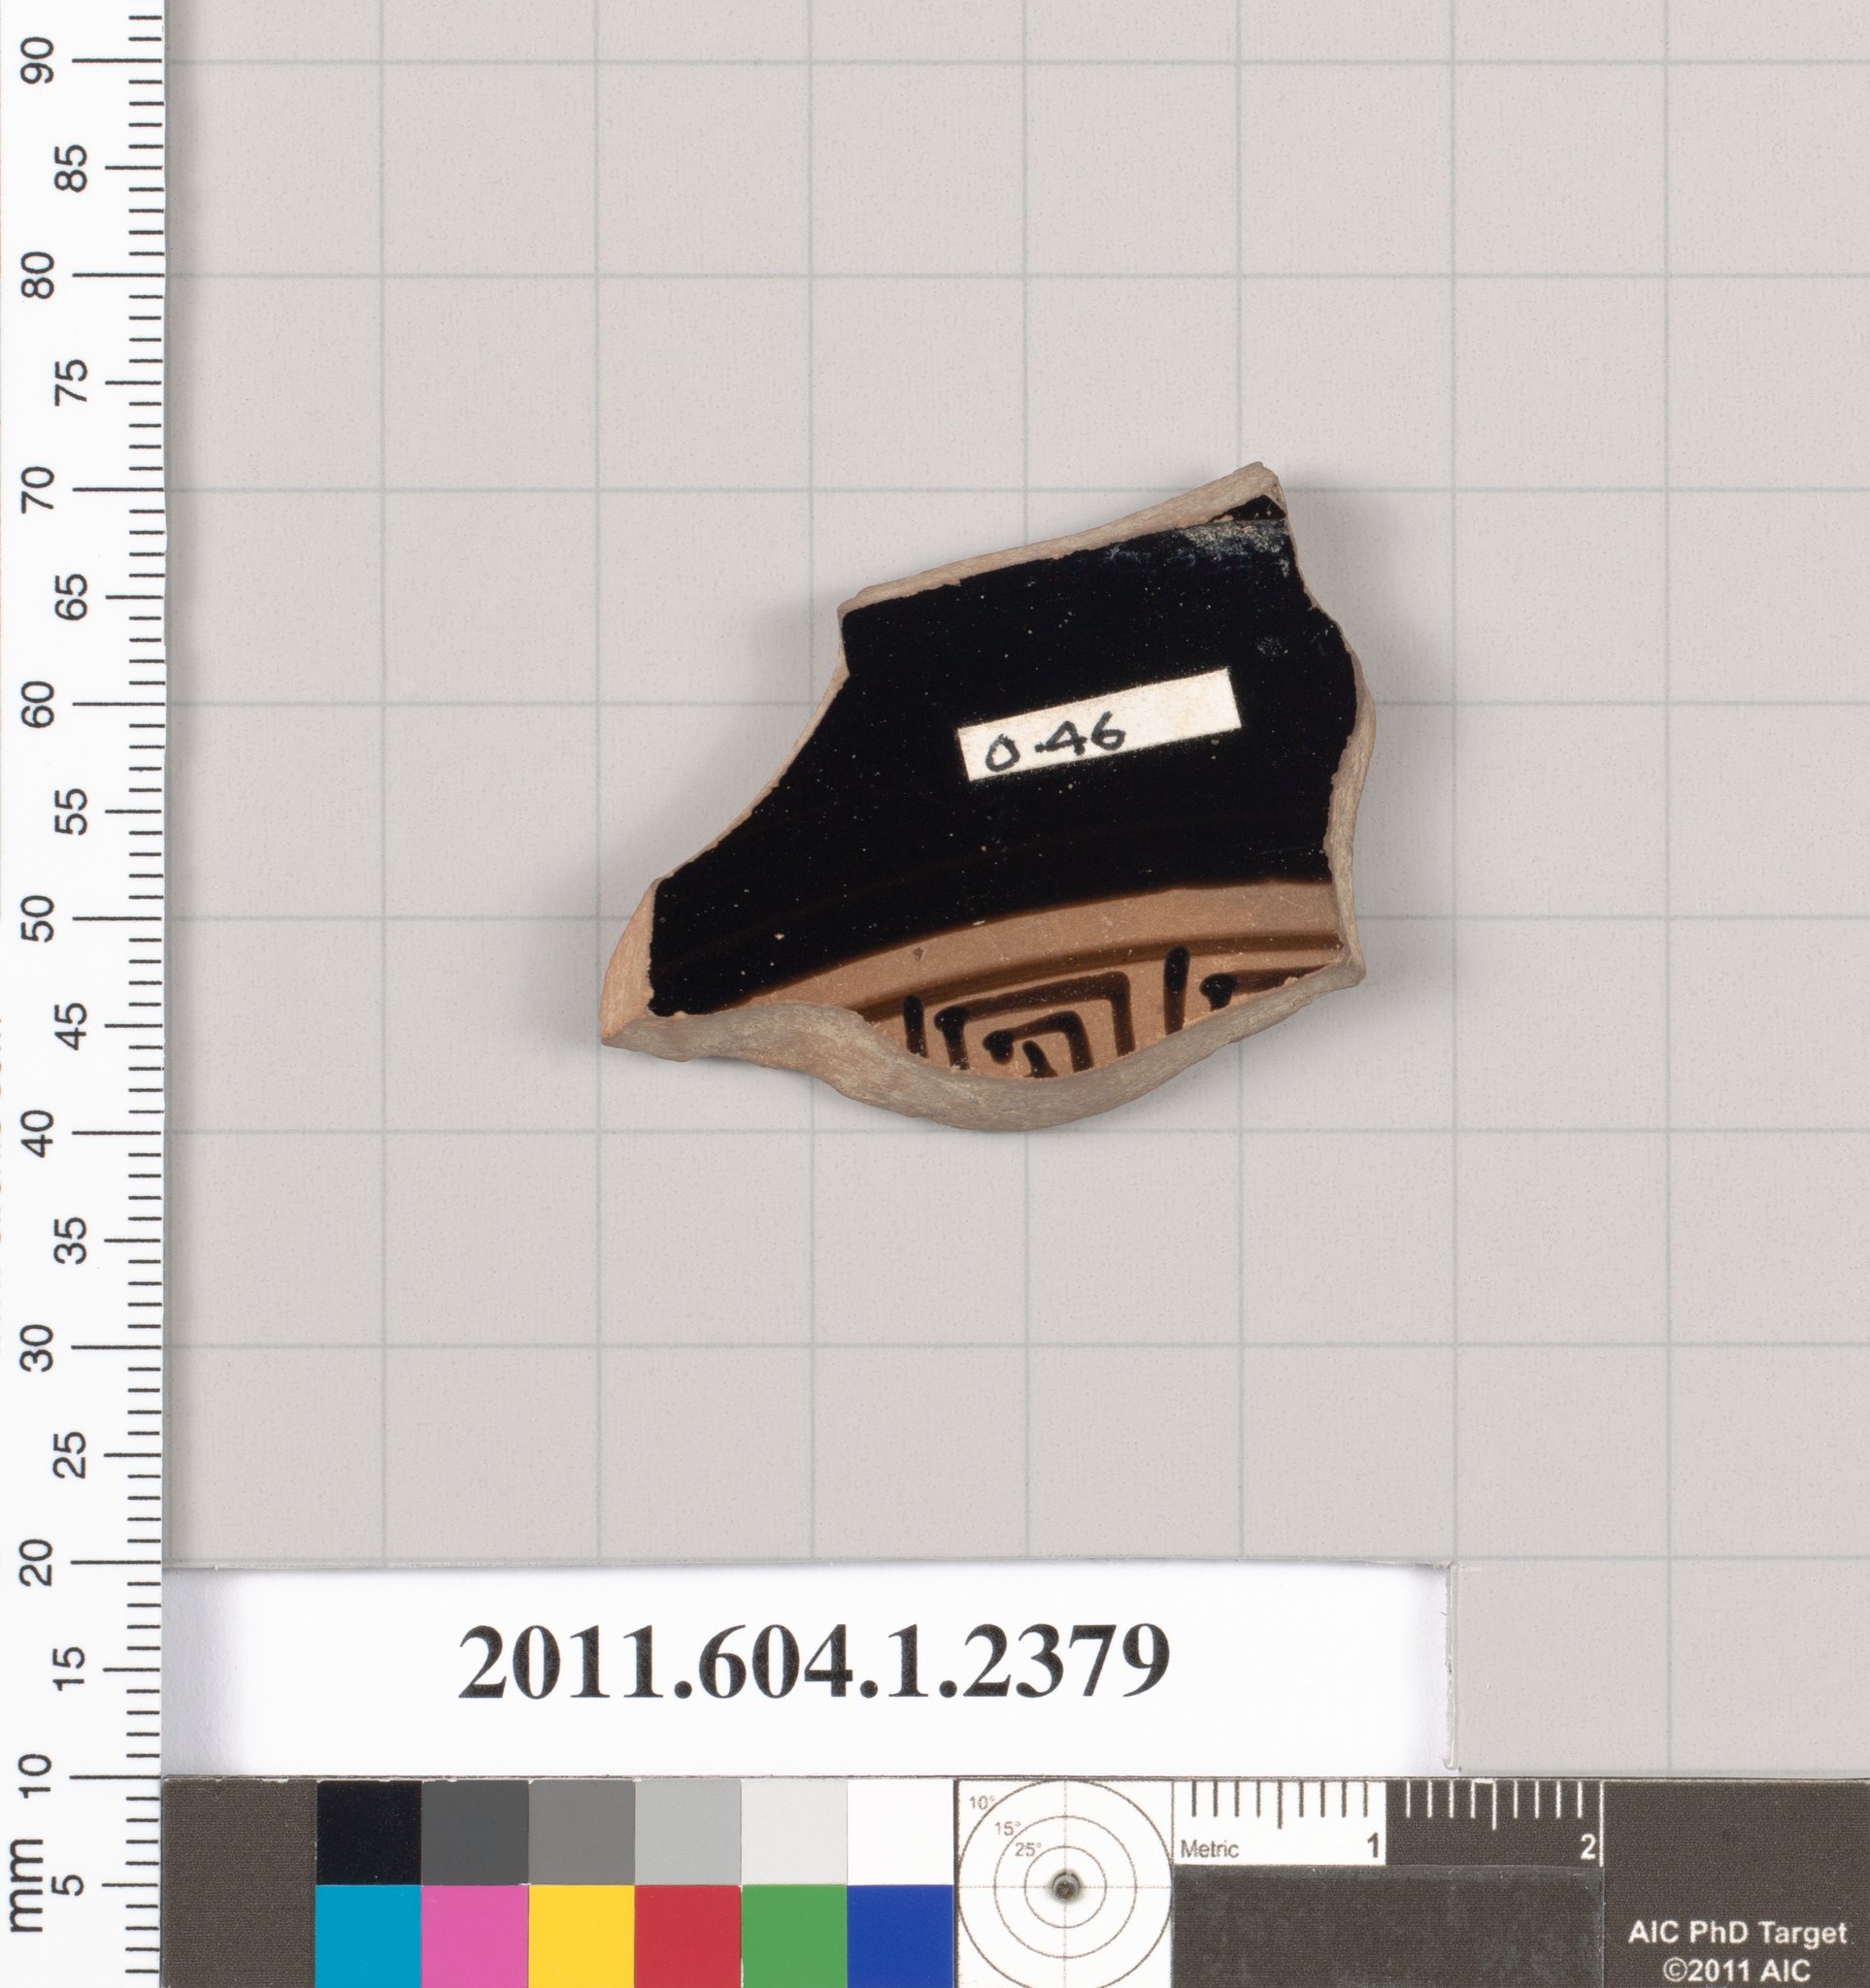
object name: kylix fragment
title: Terracotta fragment of a kylix (drinking cup)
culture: greek, attic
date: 467-435 BCE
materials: terracotta